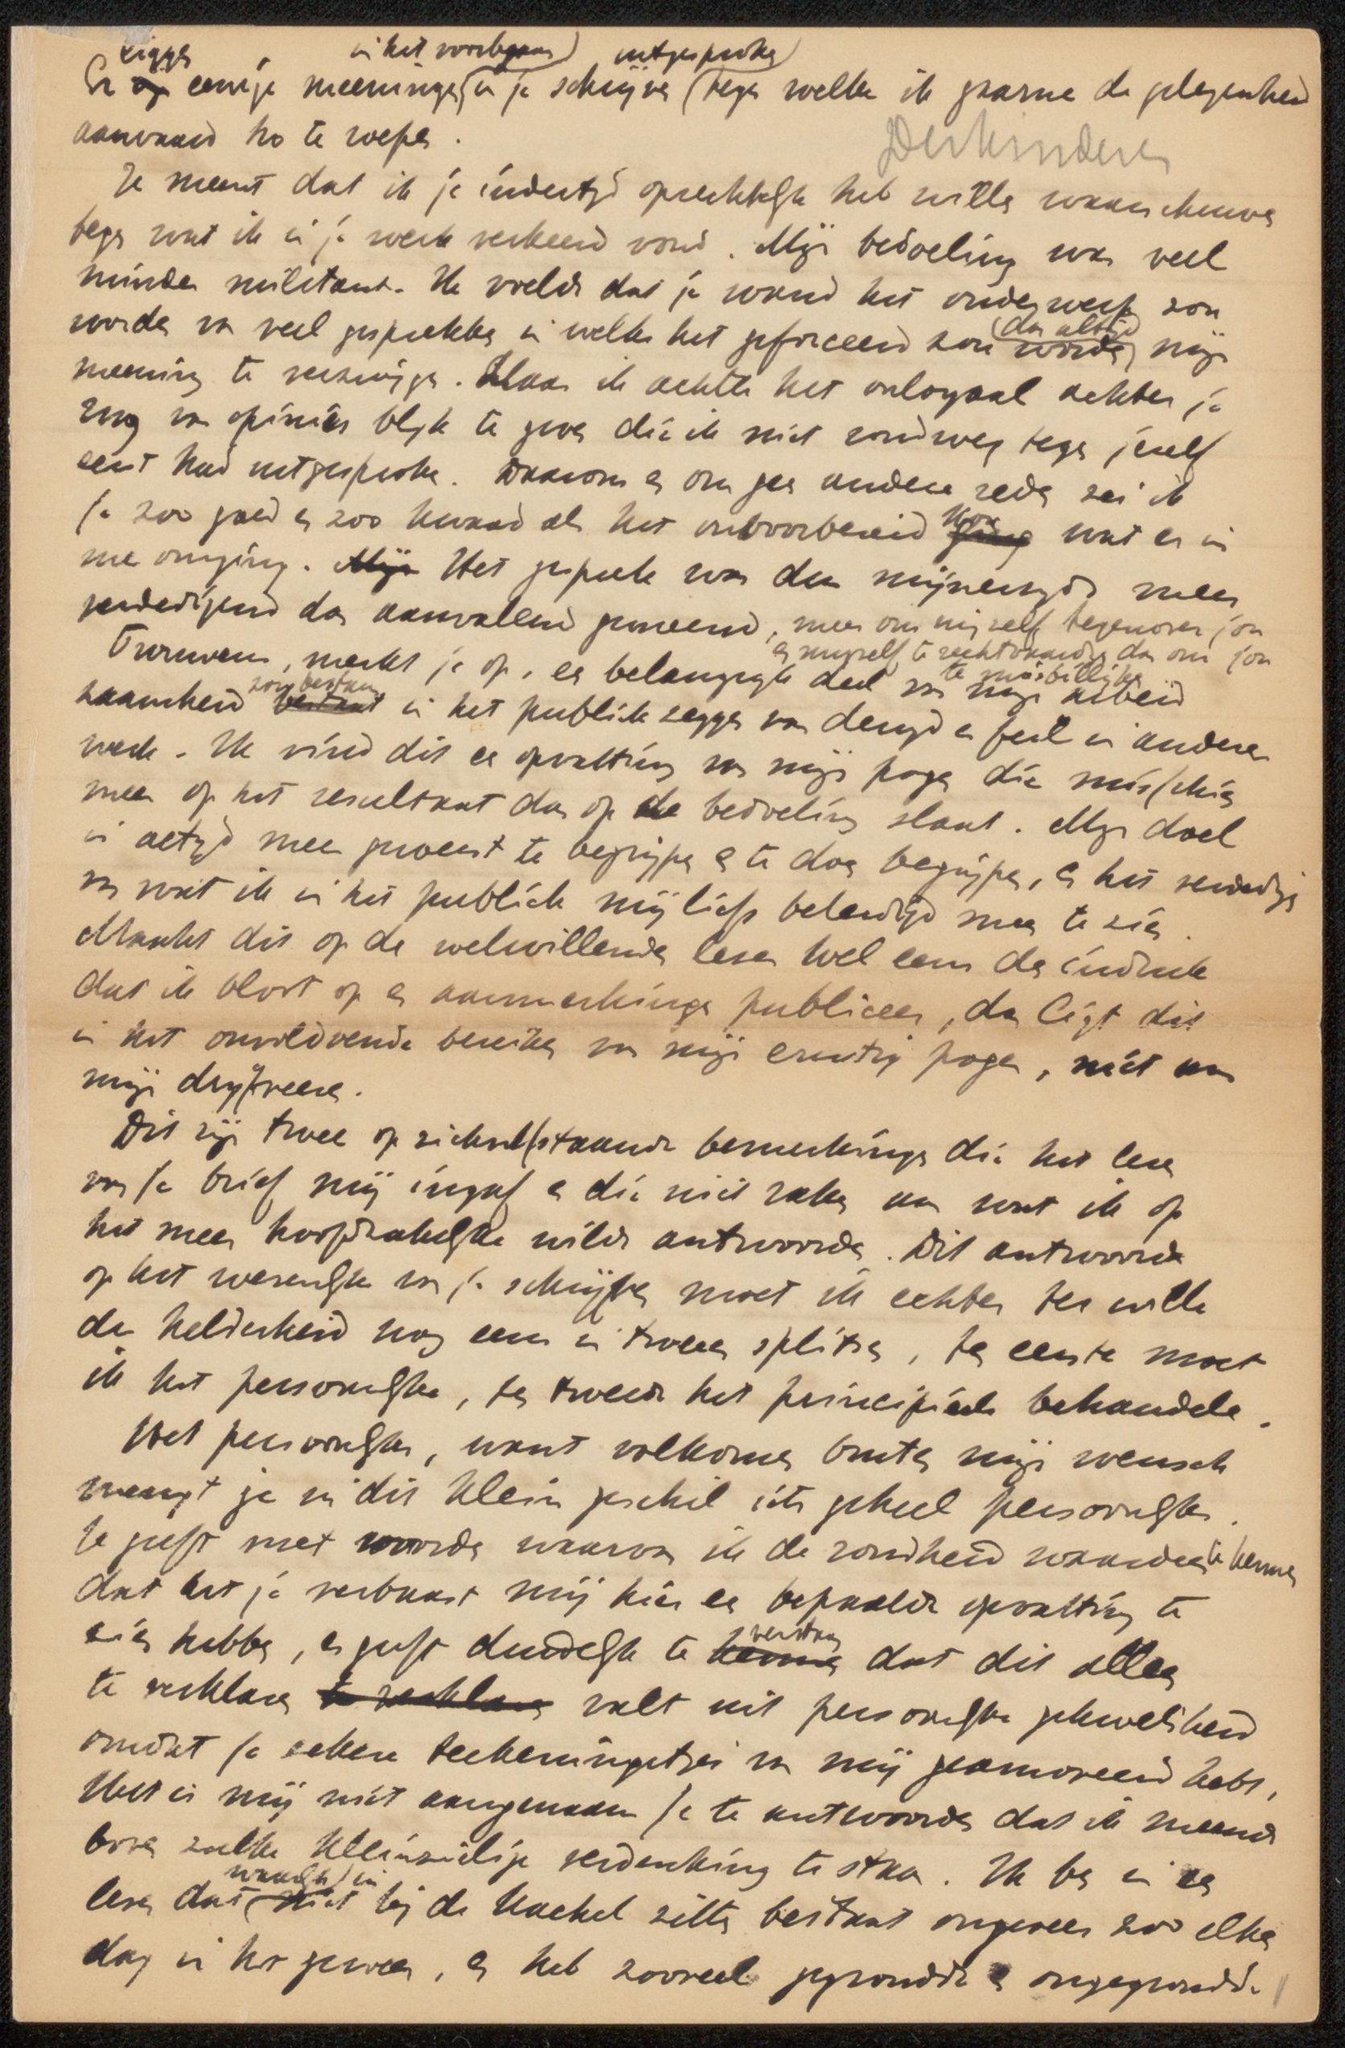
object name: letter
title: Brief aan Antoon Derkinderen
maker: jan veth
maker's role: designer, draughtsman, painter, print maker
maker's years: 1864-1925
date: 1874-1925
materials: ink, paper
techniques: pen, writing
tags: ferdinand hart nibbrig, den bosch, antoon derkinderen, drawing, the graphic arts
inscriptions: collector's mark: ‘RPK’